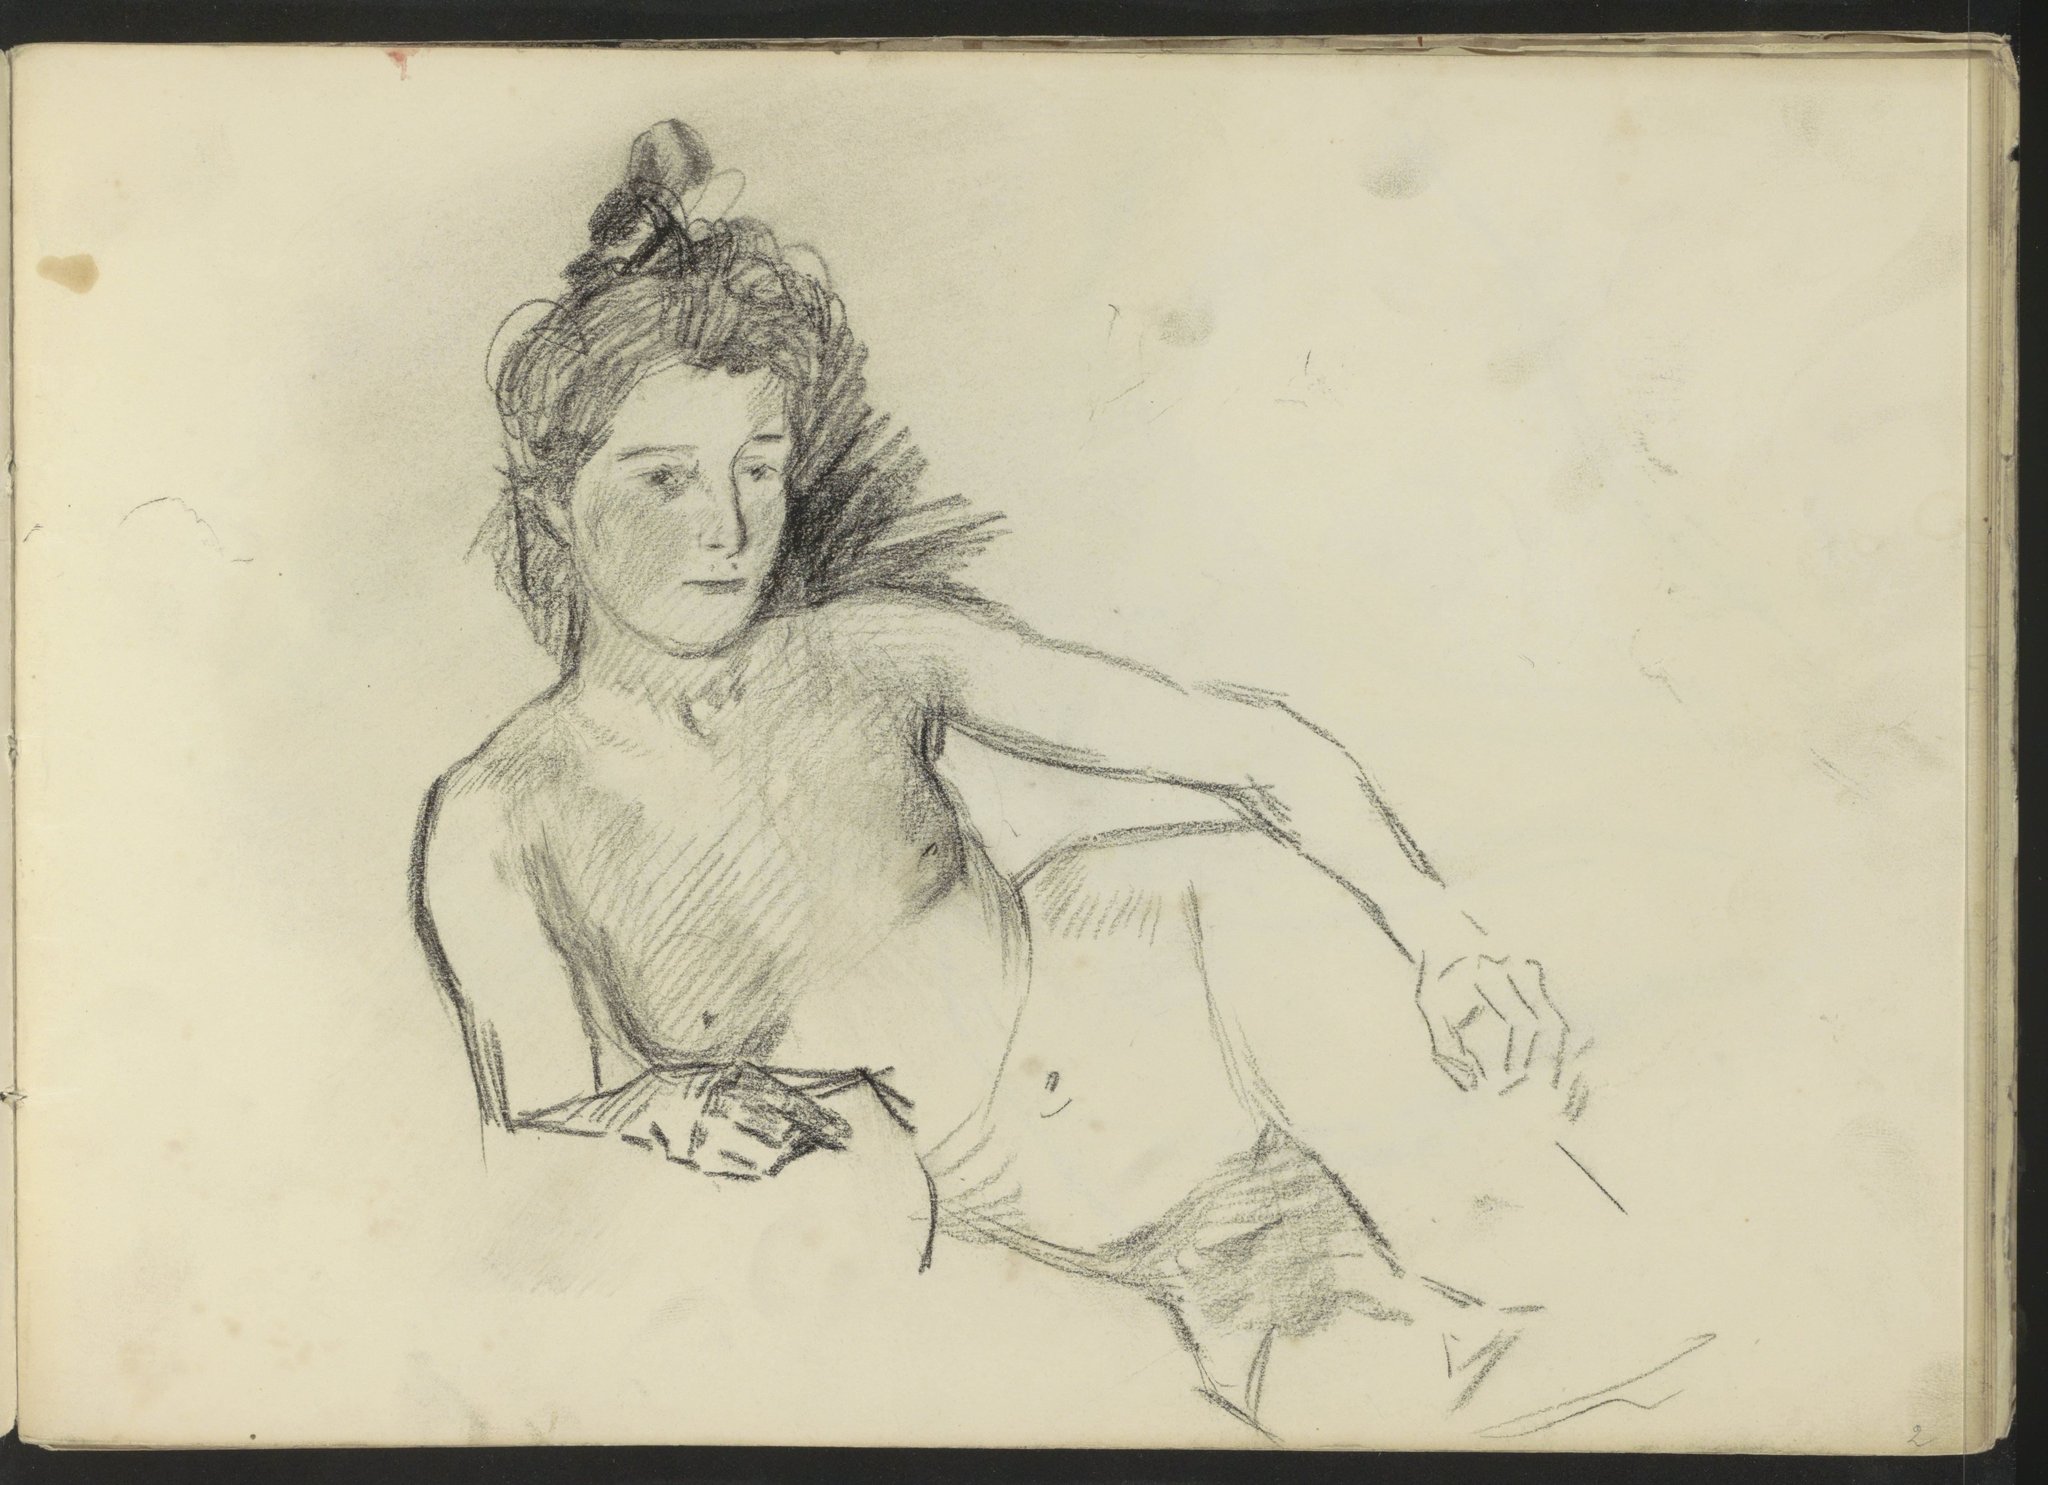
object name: sketchbook leaf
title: Reclining Female Nude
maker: isaac israels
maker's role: draughtsman, painter, print maker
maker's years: 1865-1934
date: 1875-1934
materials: chalk, paper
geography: the hague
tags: the (nude) human figure; 'corpo humano' (ripa) - aa - female human figure (+ lying)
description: Ze leunt op een arm. Blad 2 recto uit schetsboek XII met 19 bladen.